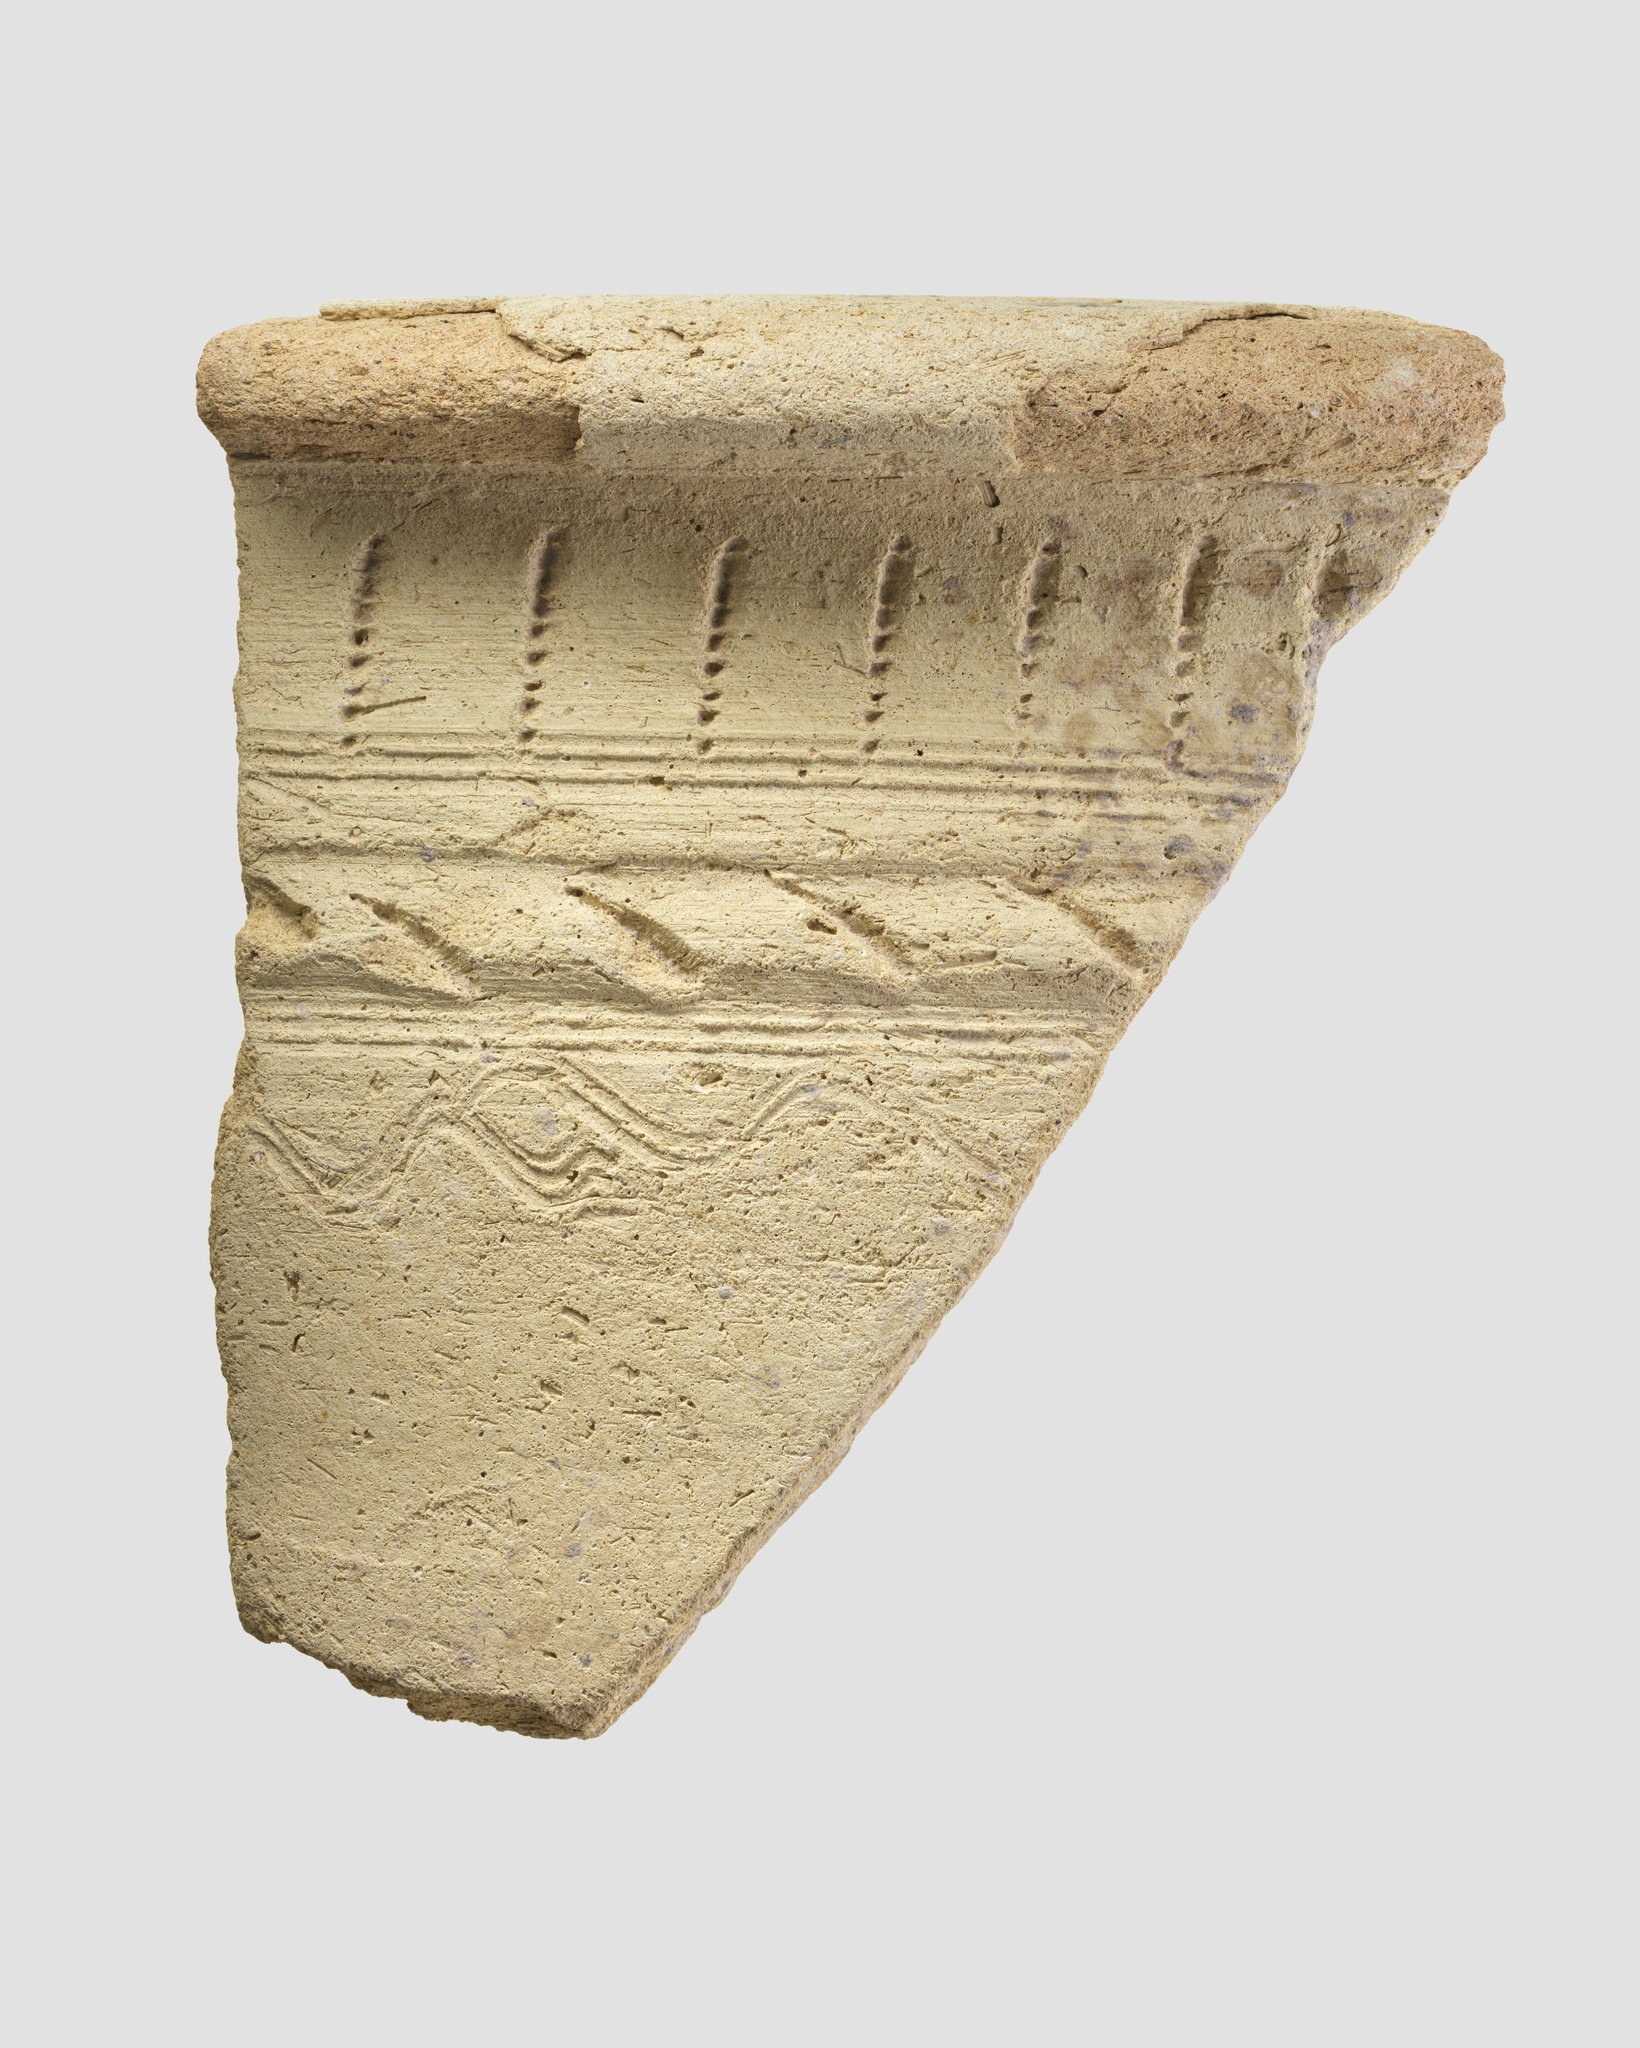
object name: sherd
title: Rim sherd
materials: ceramic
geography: mesopotamia